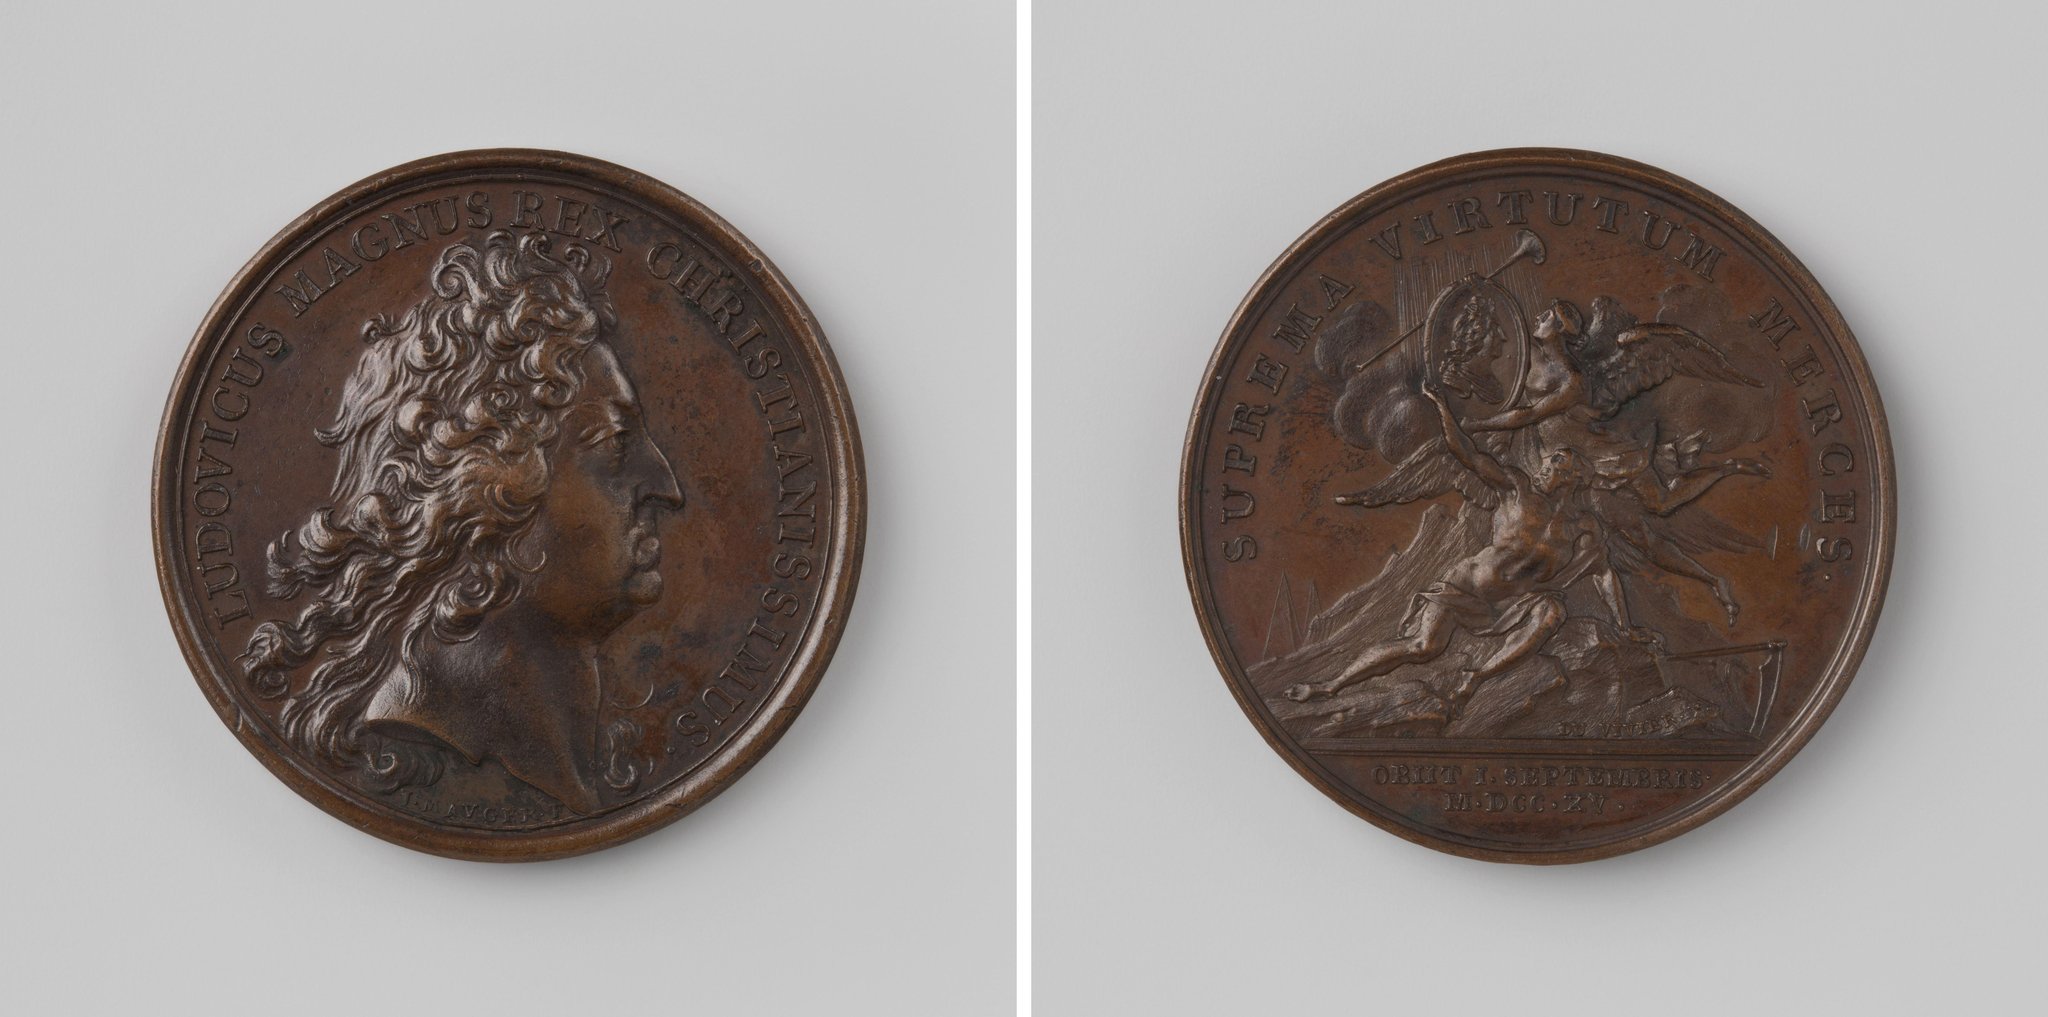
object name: history medal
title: Overlijden van Lodewijk XIV, koning van Frankrijk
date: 1715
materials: bronze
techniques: striking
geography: paris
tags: lodewijk xiv (koning van frankrijk)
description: Bronzen penning. Voorzijde: borststuk man binnen omschrift. Keerzijde: Faam met bazuin in hand ontneemt Tijd portret met beeldtenis van overleden koning binnen omschrift; afsnede: opschrift.